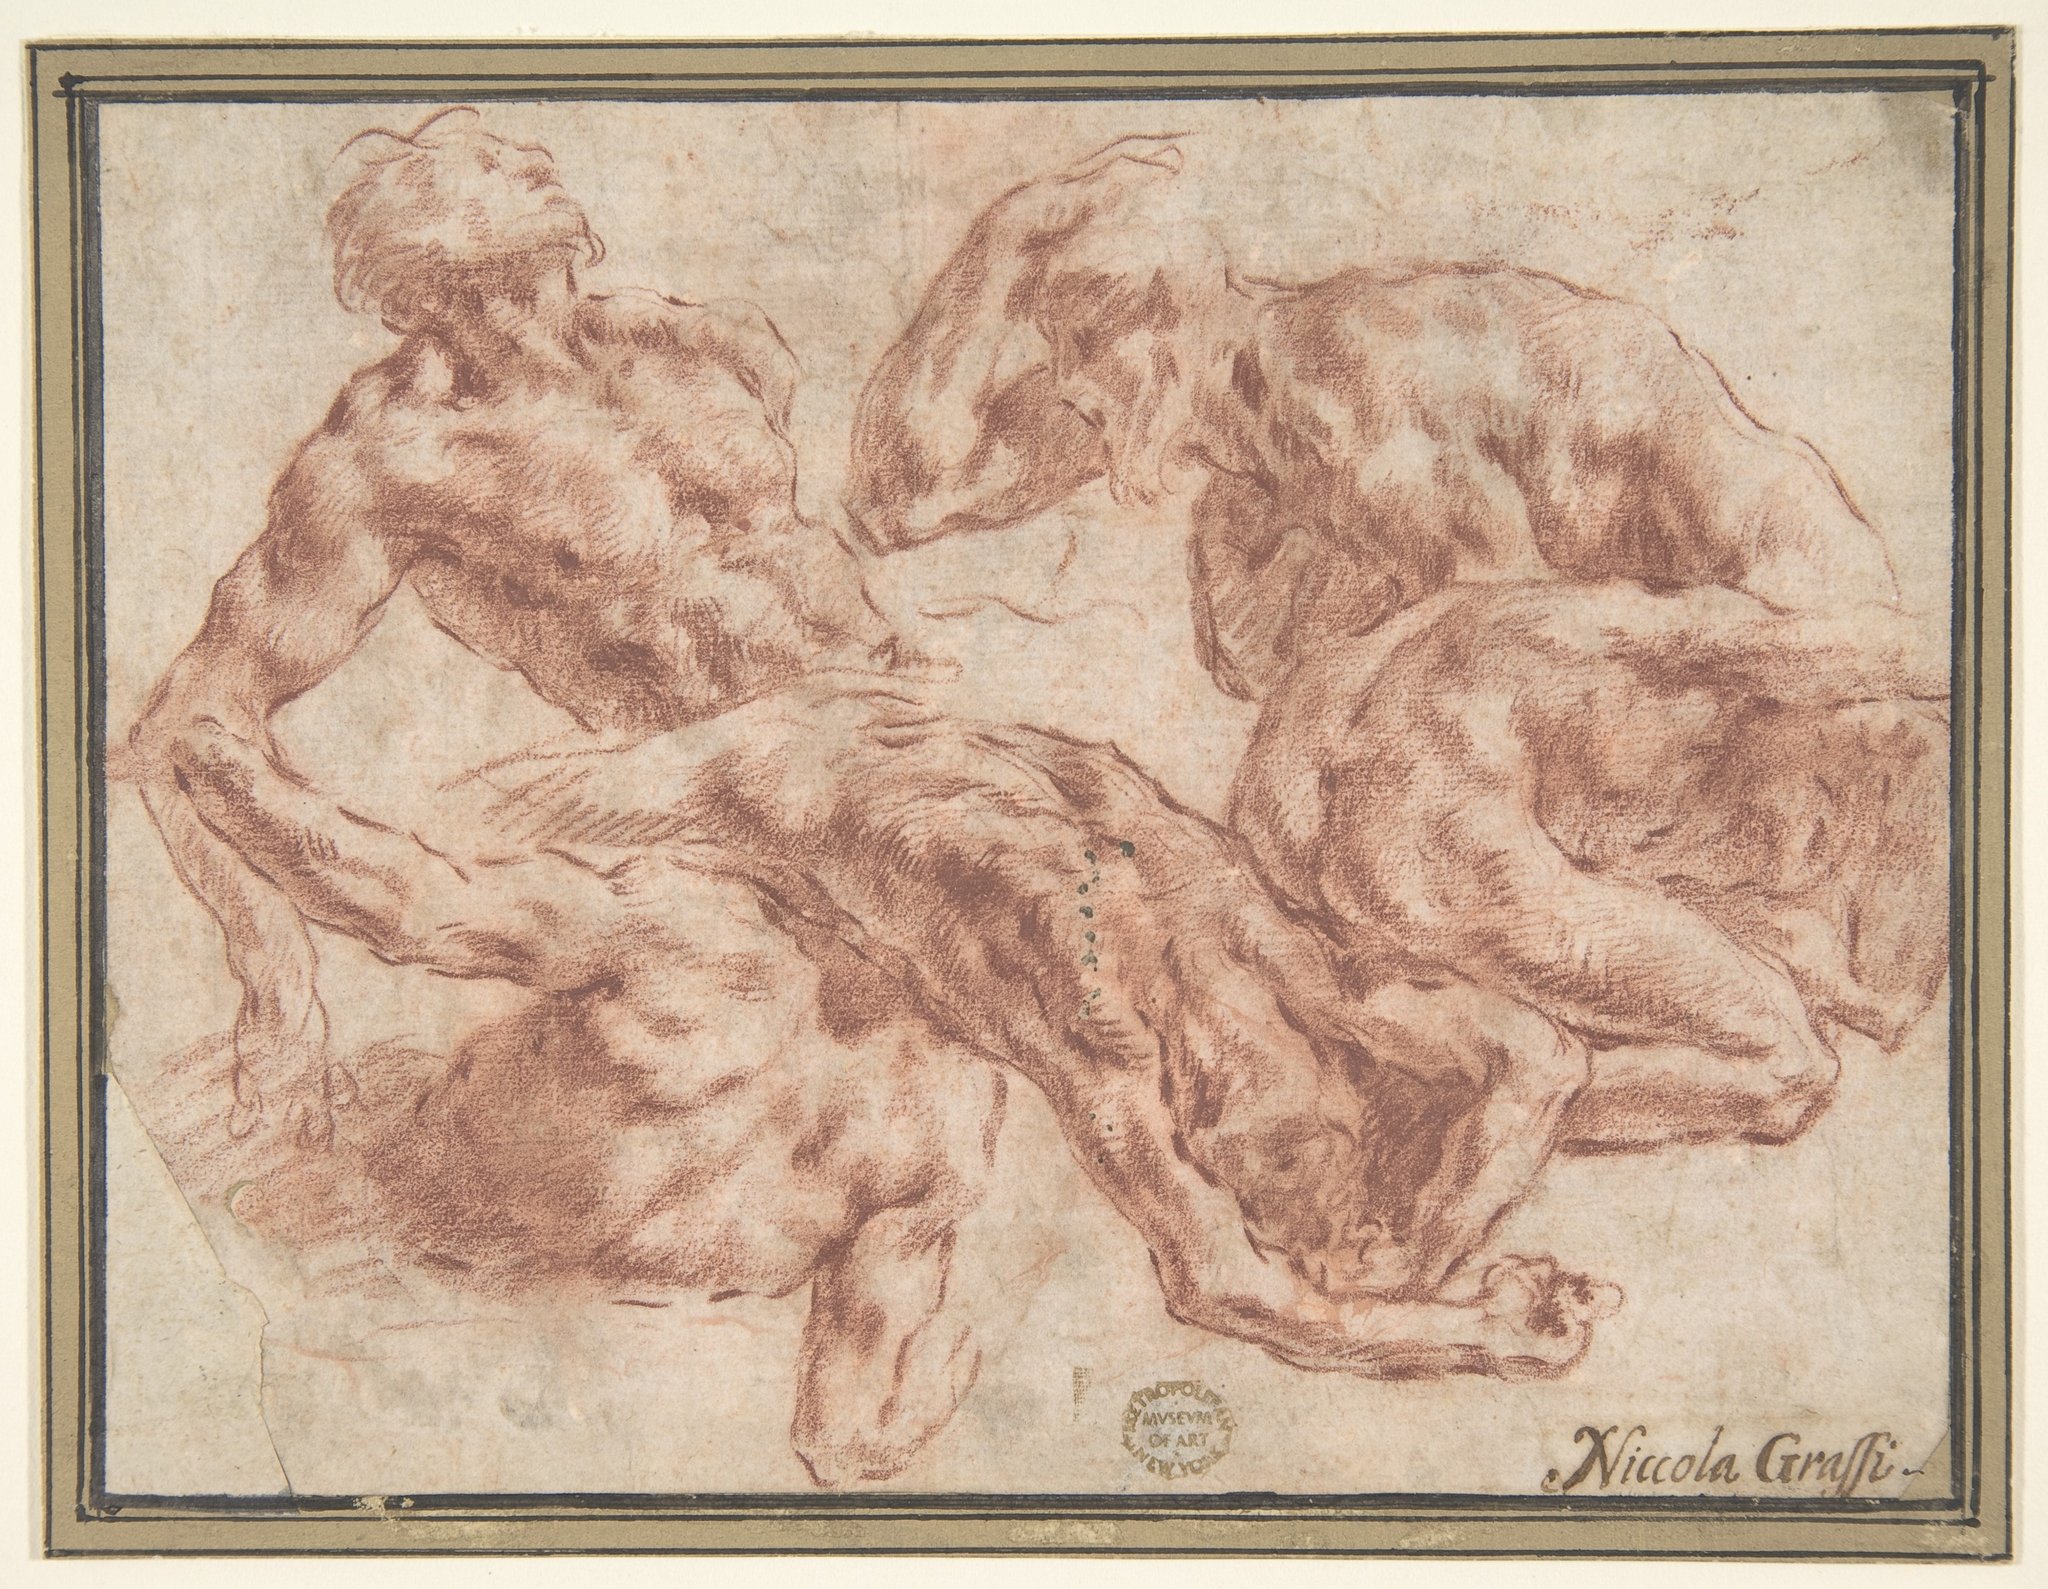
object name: drawing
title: Studies of Nude Men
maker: nicola grassi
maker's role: artist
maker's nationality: italian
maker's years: 1682-1750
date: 1682-1750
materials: chalk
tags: male nudes